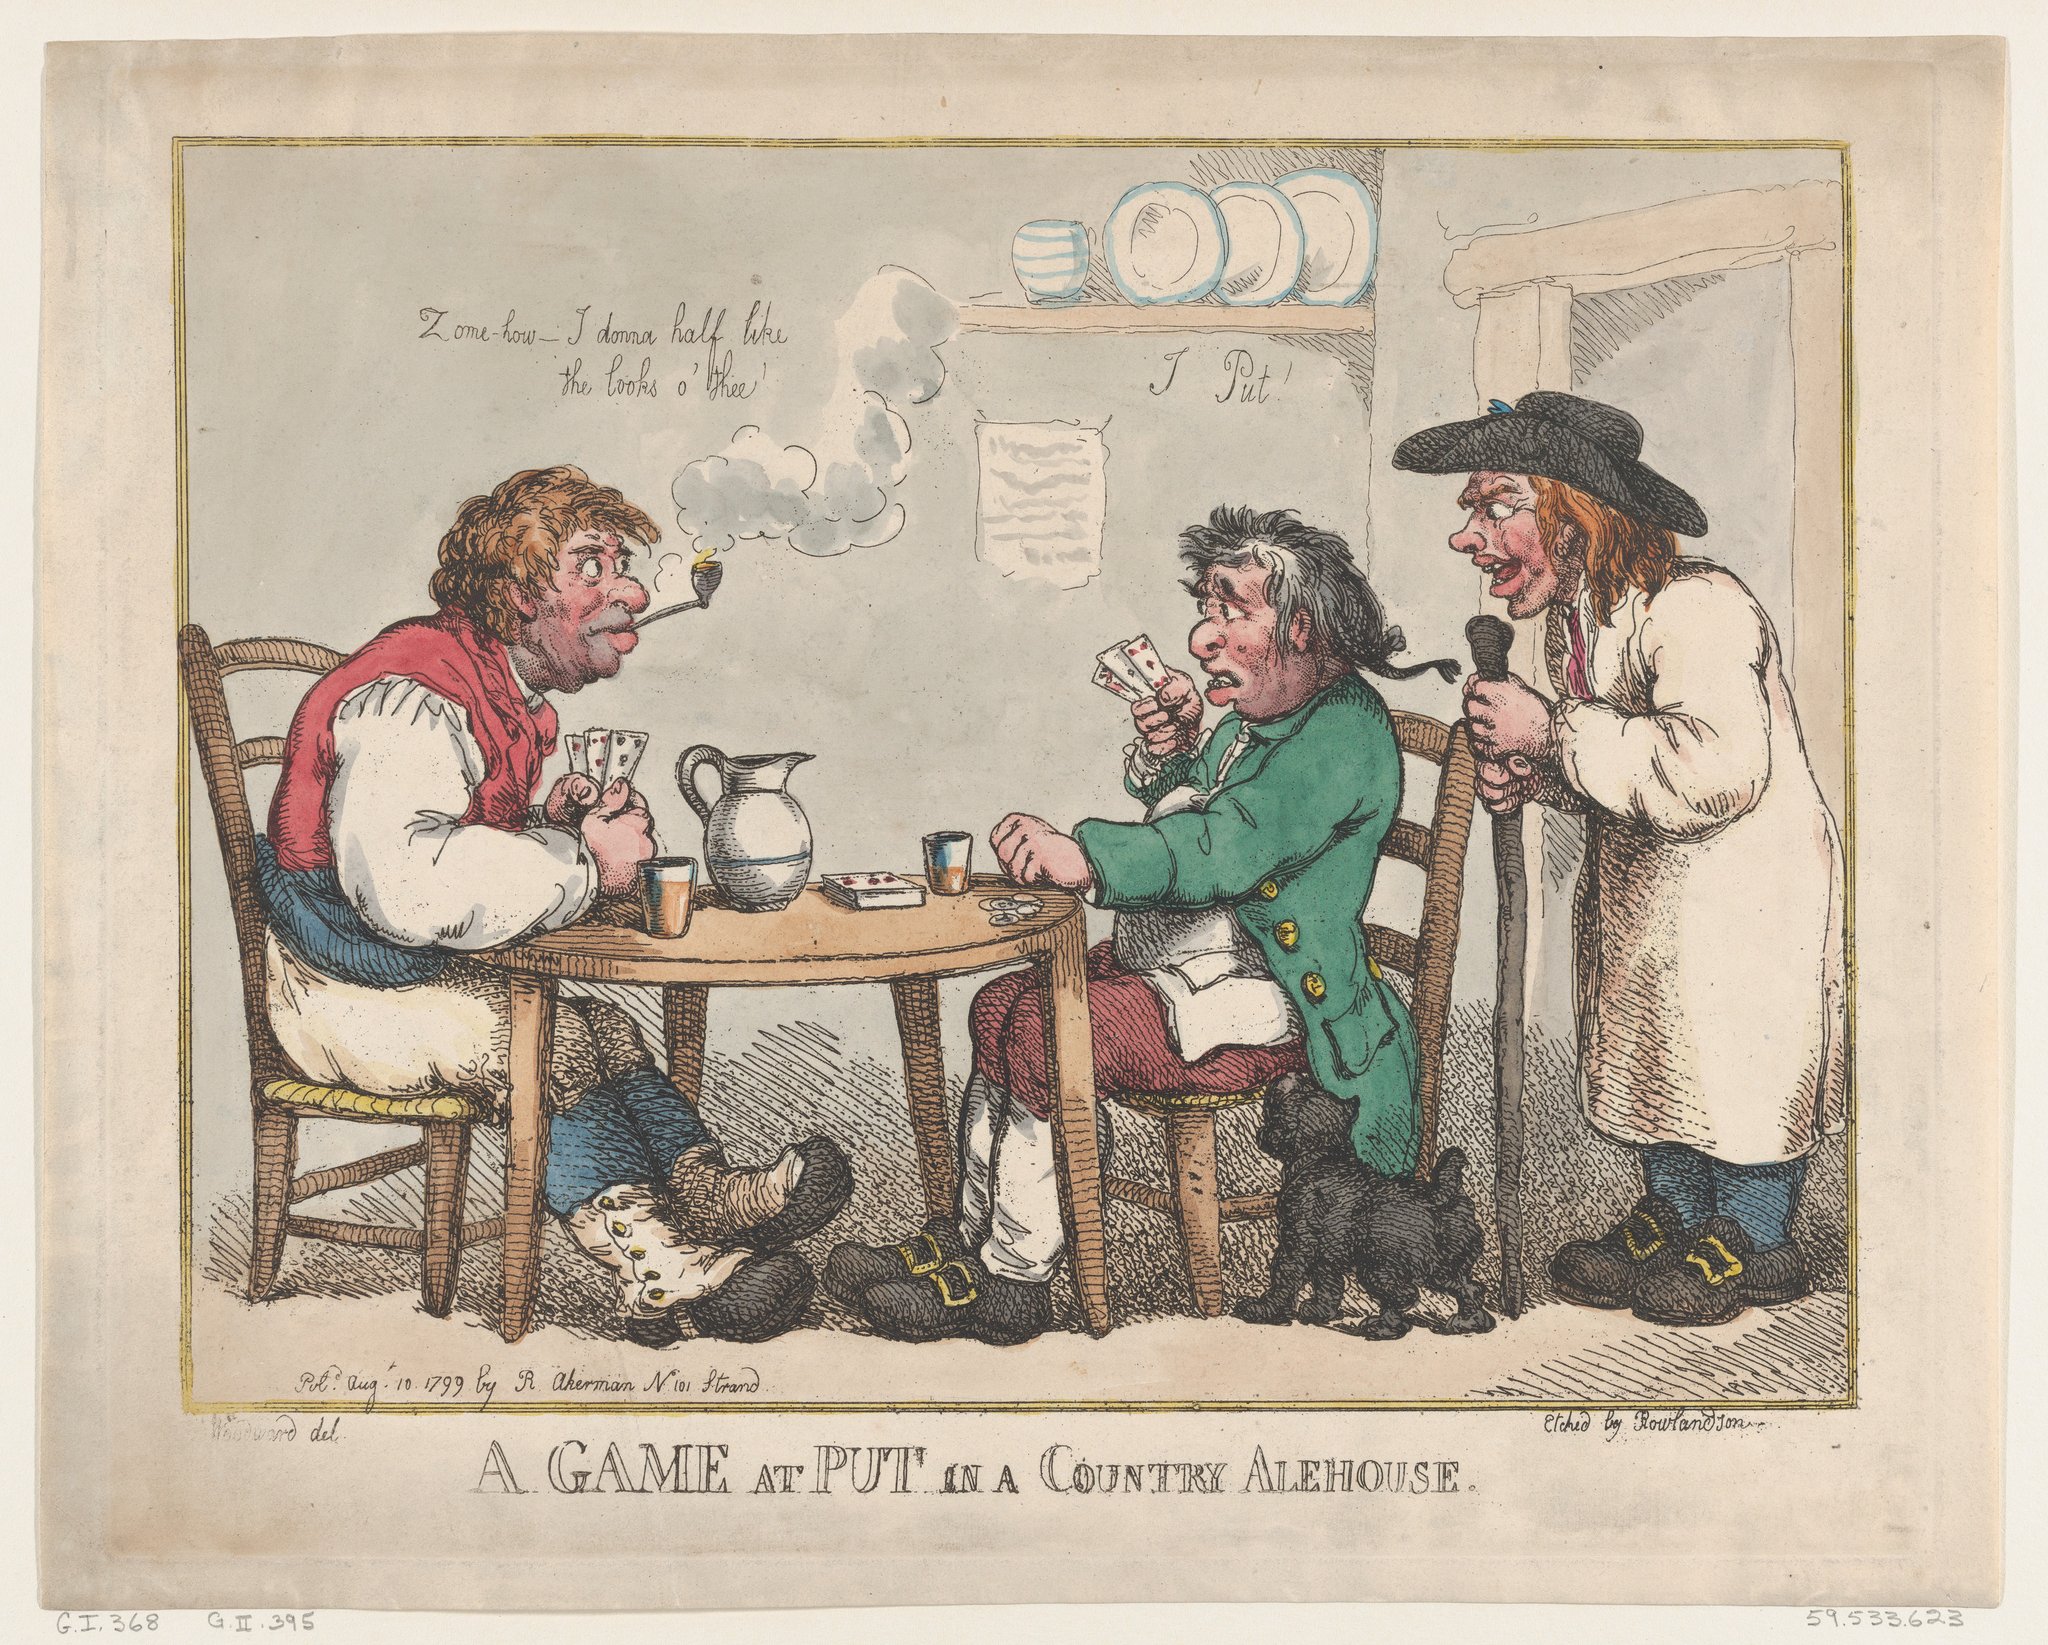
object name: print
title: A Game at Put in a Country Alehouse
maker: thomas rowlandson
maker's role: artist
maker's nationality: british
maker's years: 1757-1827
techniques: etching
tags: men,playing cards,smoking,dogs